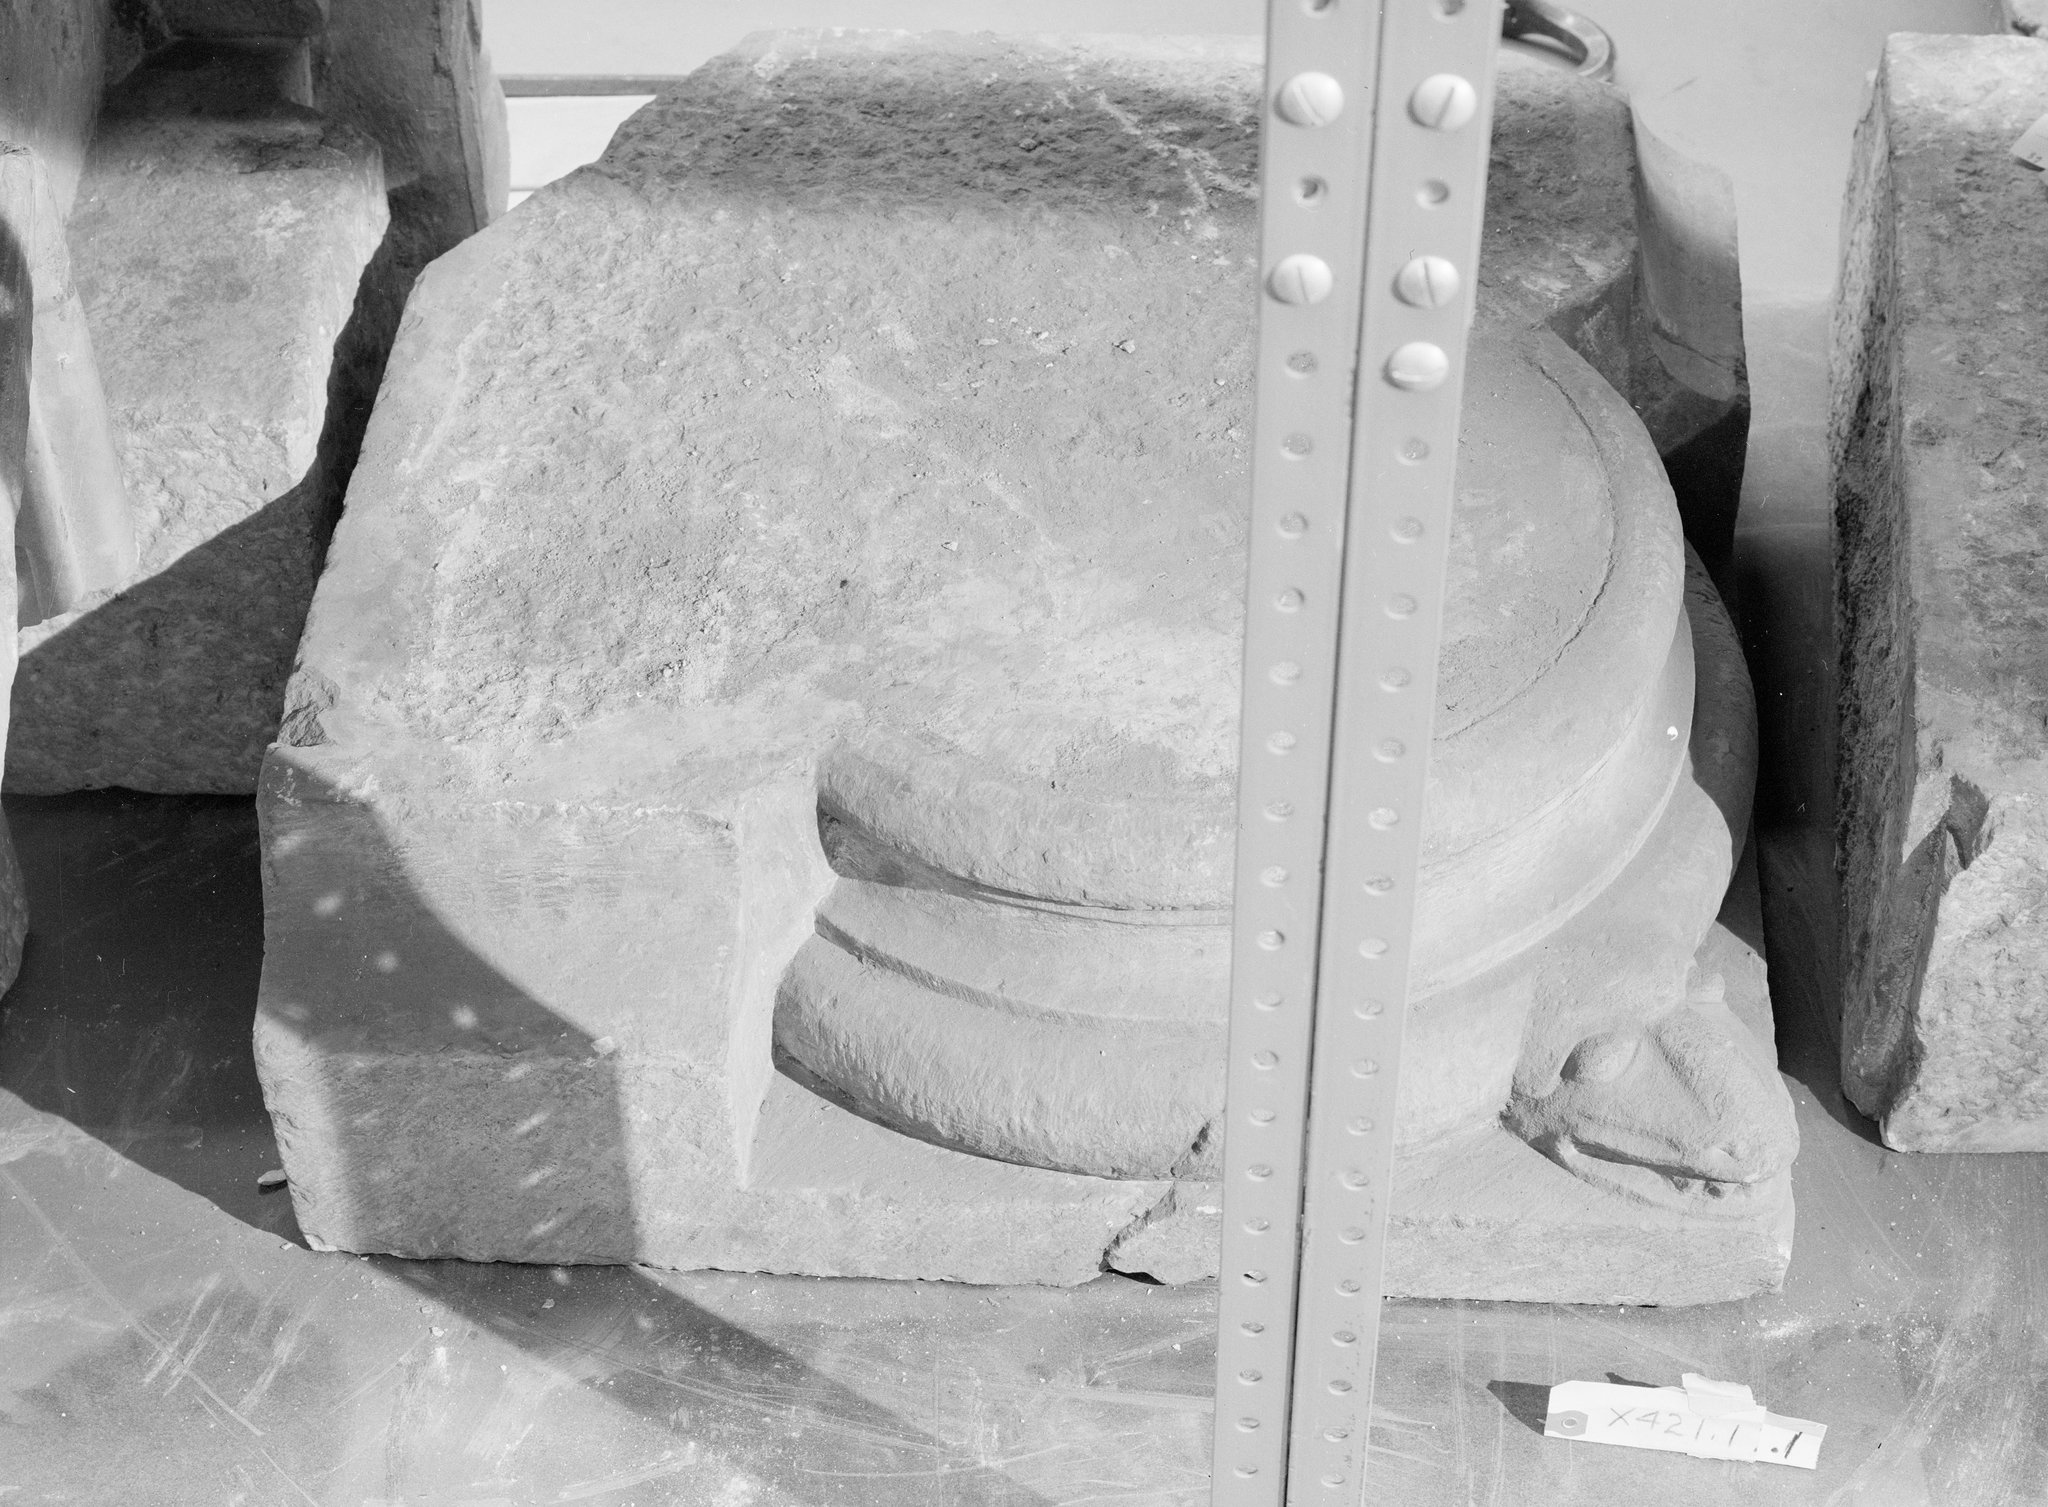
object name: base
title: Base, engaged with animal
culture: french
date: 1130-1140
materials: stone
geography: france